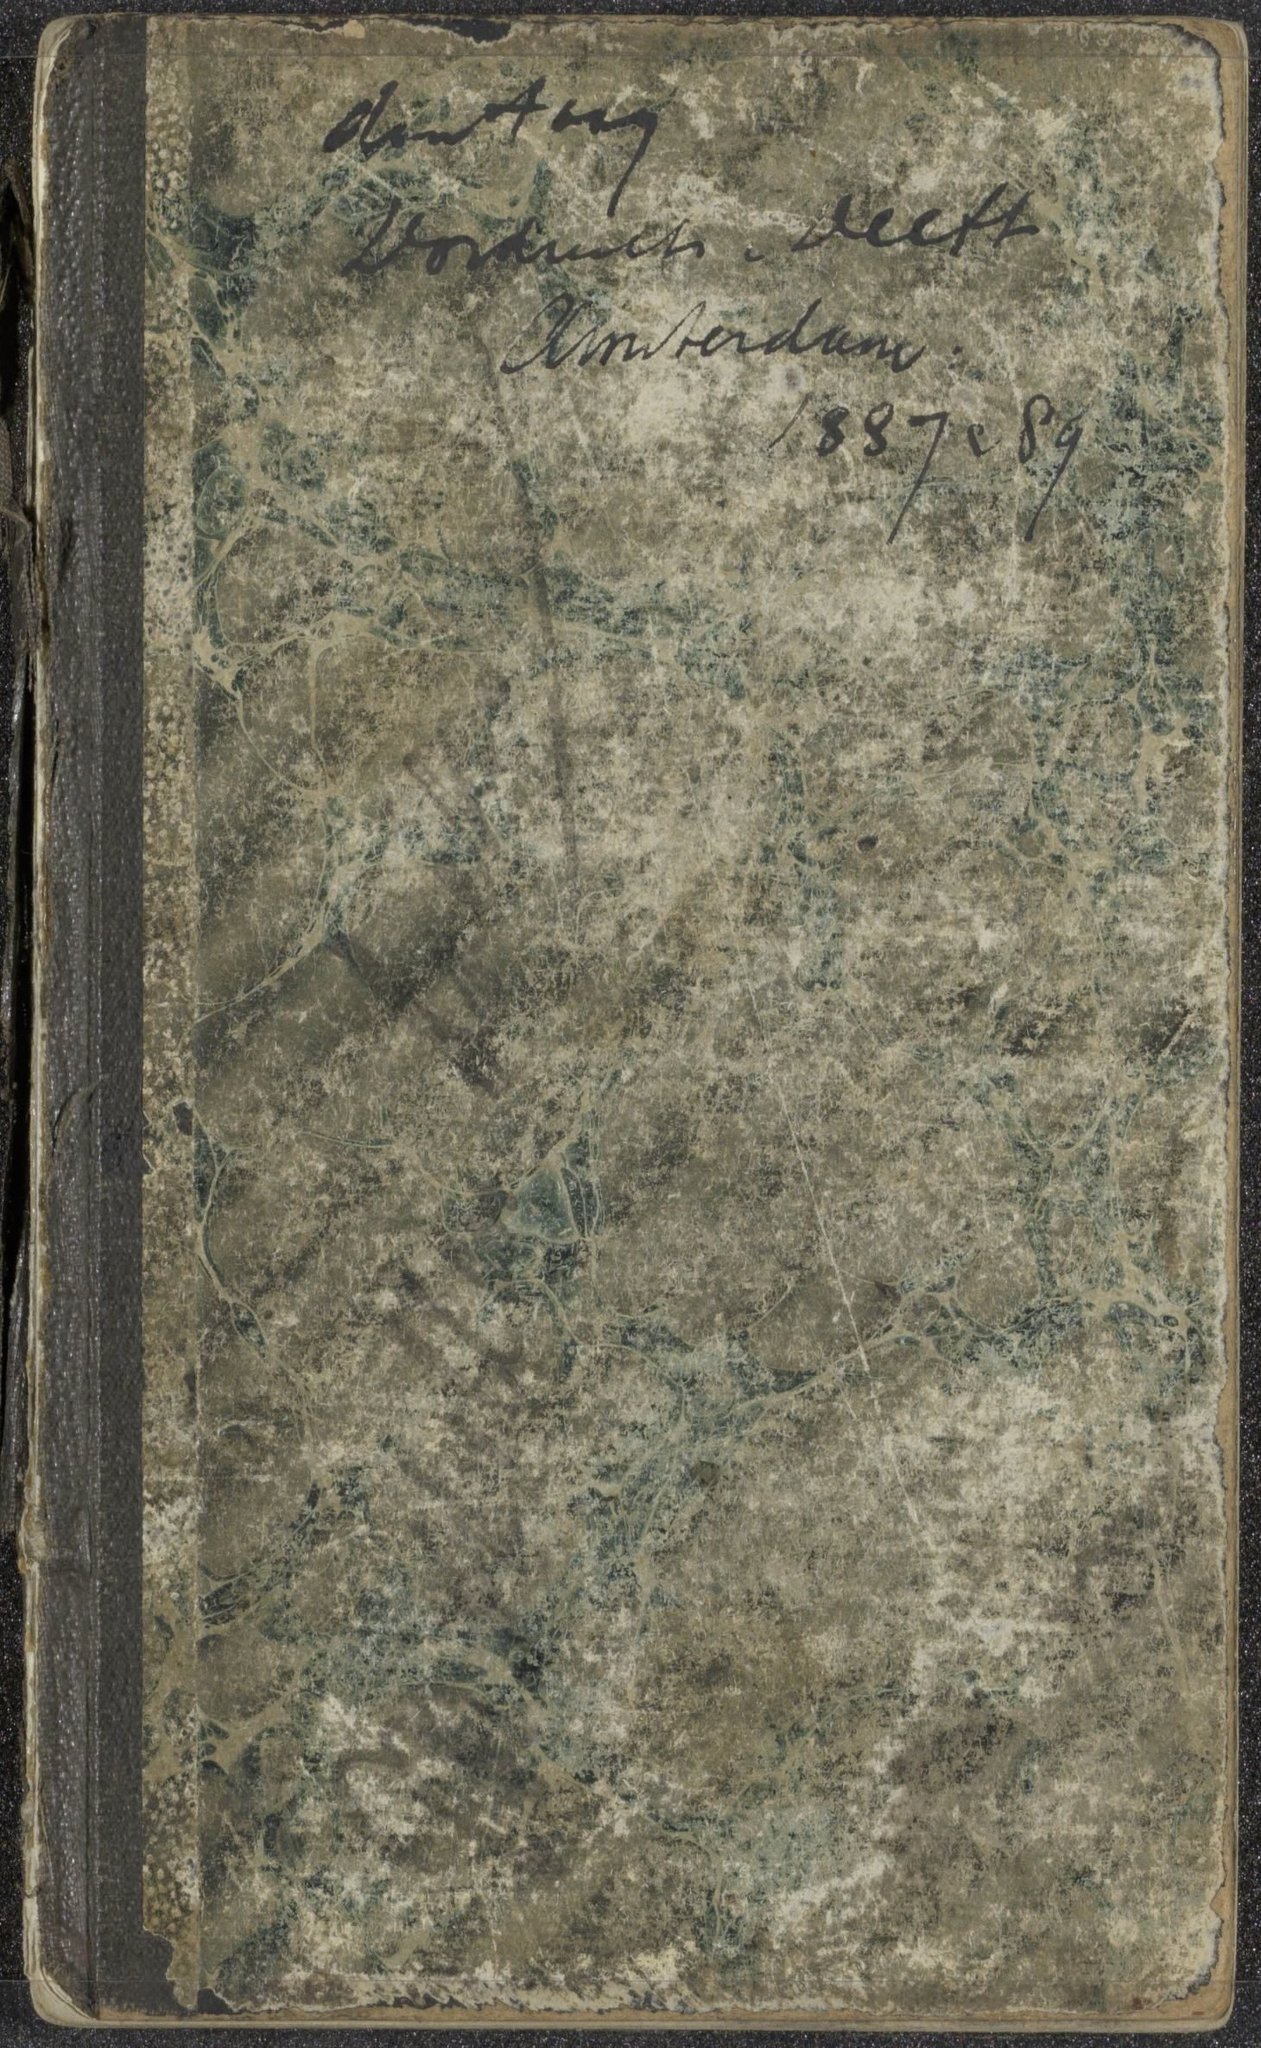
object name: sketchbook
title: Schetsboek met 27 bladen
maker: george hendrik breitner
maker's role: draughtsman, painter, print maker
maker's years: 1857-1923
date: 1887-1889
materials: cardboard, chalk, linen, paper, pencil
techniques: marbling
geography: amsterdam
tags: cow, adult woman, adult man, child, street, the hague, delft, dordrecht, amsterdam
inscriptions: date: ‘1887 & 89’, annotation: ‘Den Haag/ Dordrecht. Delft/ Amsterdam.’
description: Schetsboek bestaande uit 27 bladen met figuurstudies, stadsgezichten, koeien en portretten.